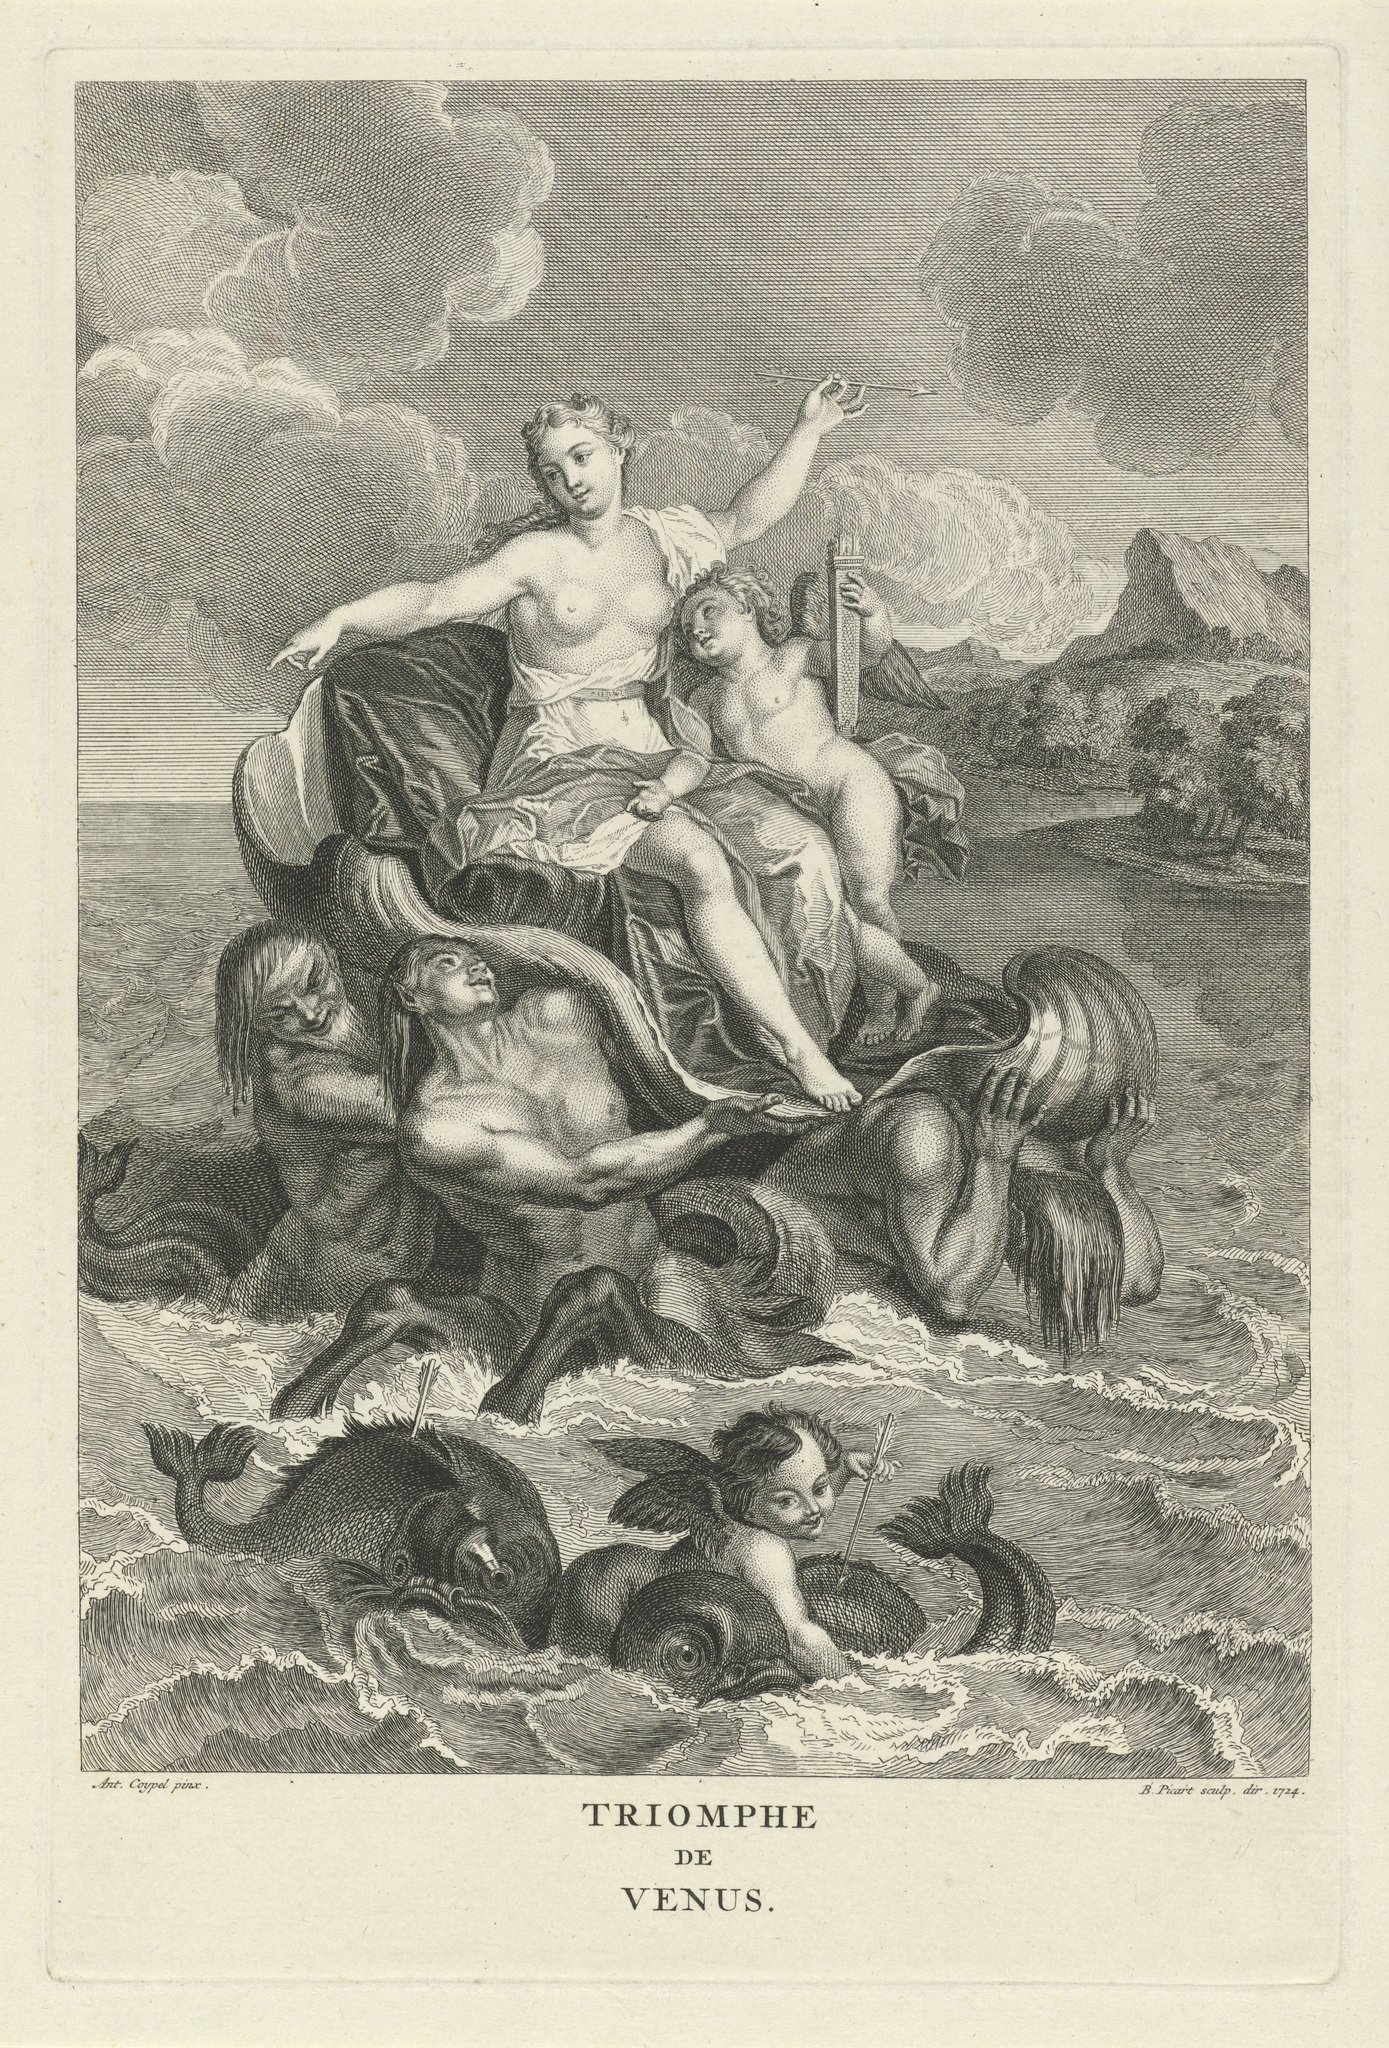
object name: print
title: Triomf van Venus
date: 1724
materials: paper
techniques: engraving, etching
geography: amsterdam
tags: triumph of venus marina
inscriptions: date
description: Venus troont op een schelp die wordt gedragen door tritons. Naast haar staat Amor, met zijn pijlenkoker in de hand.